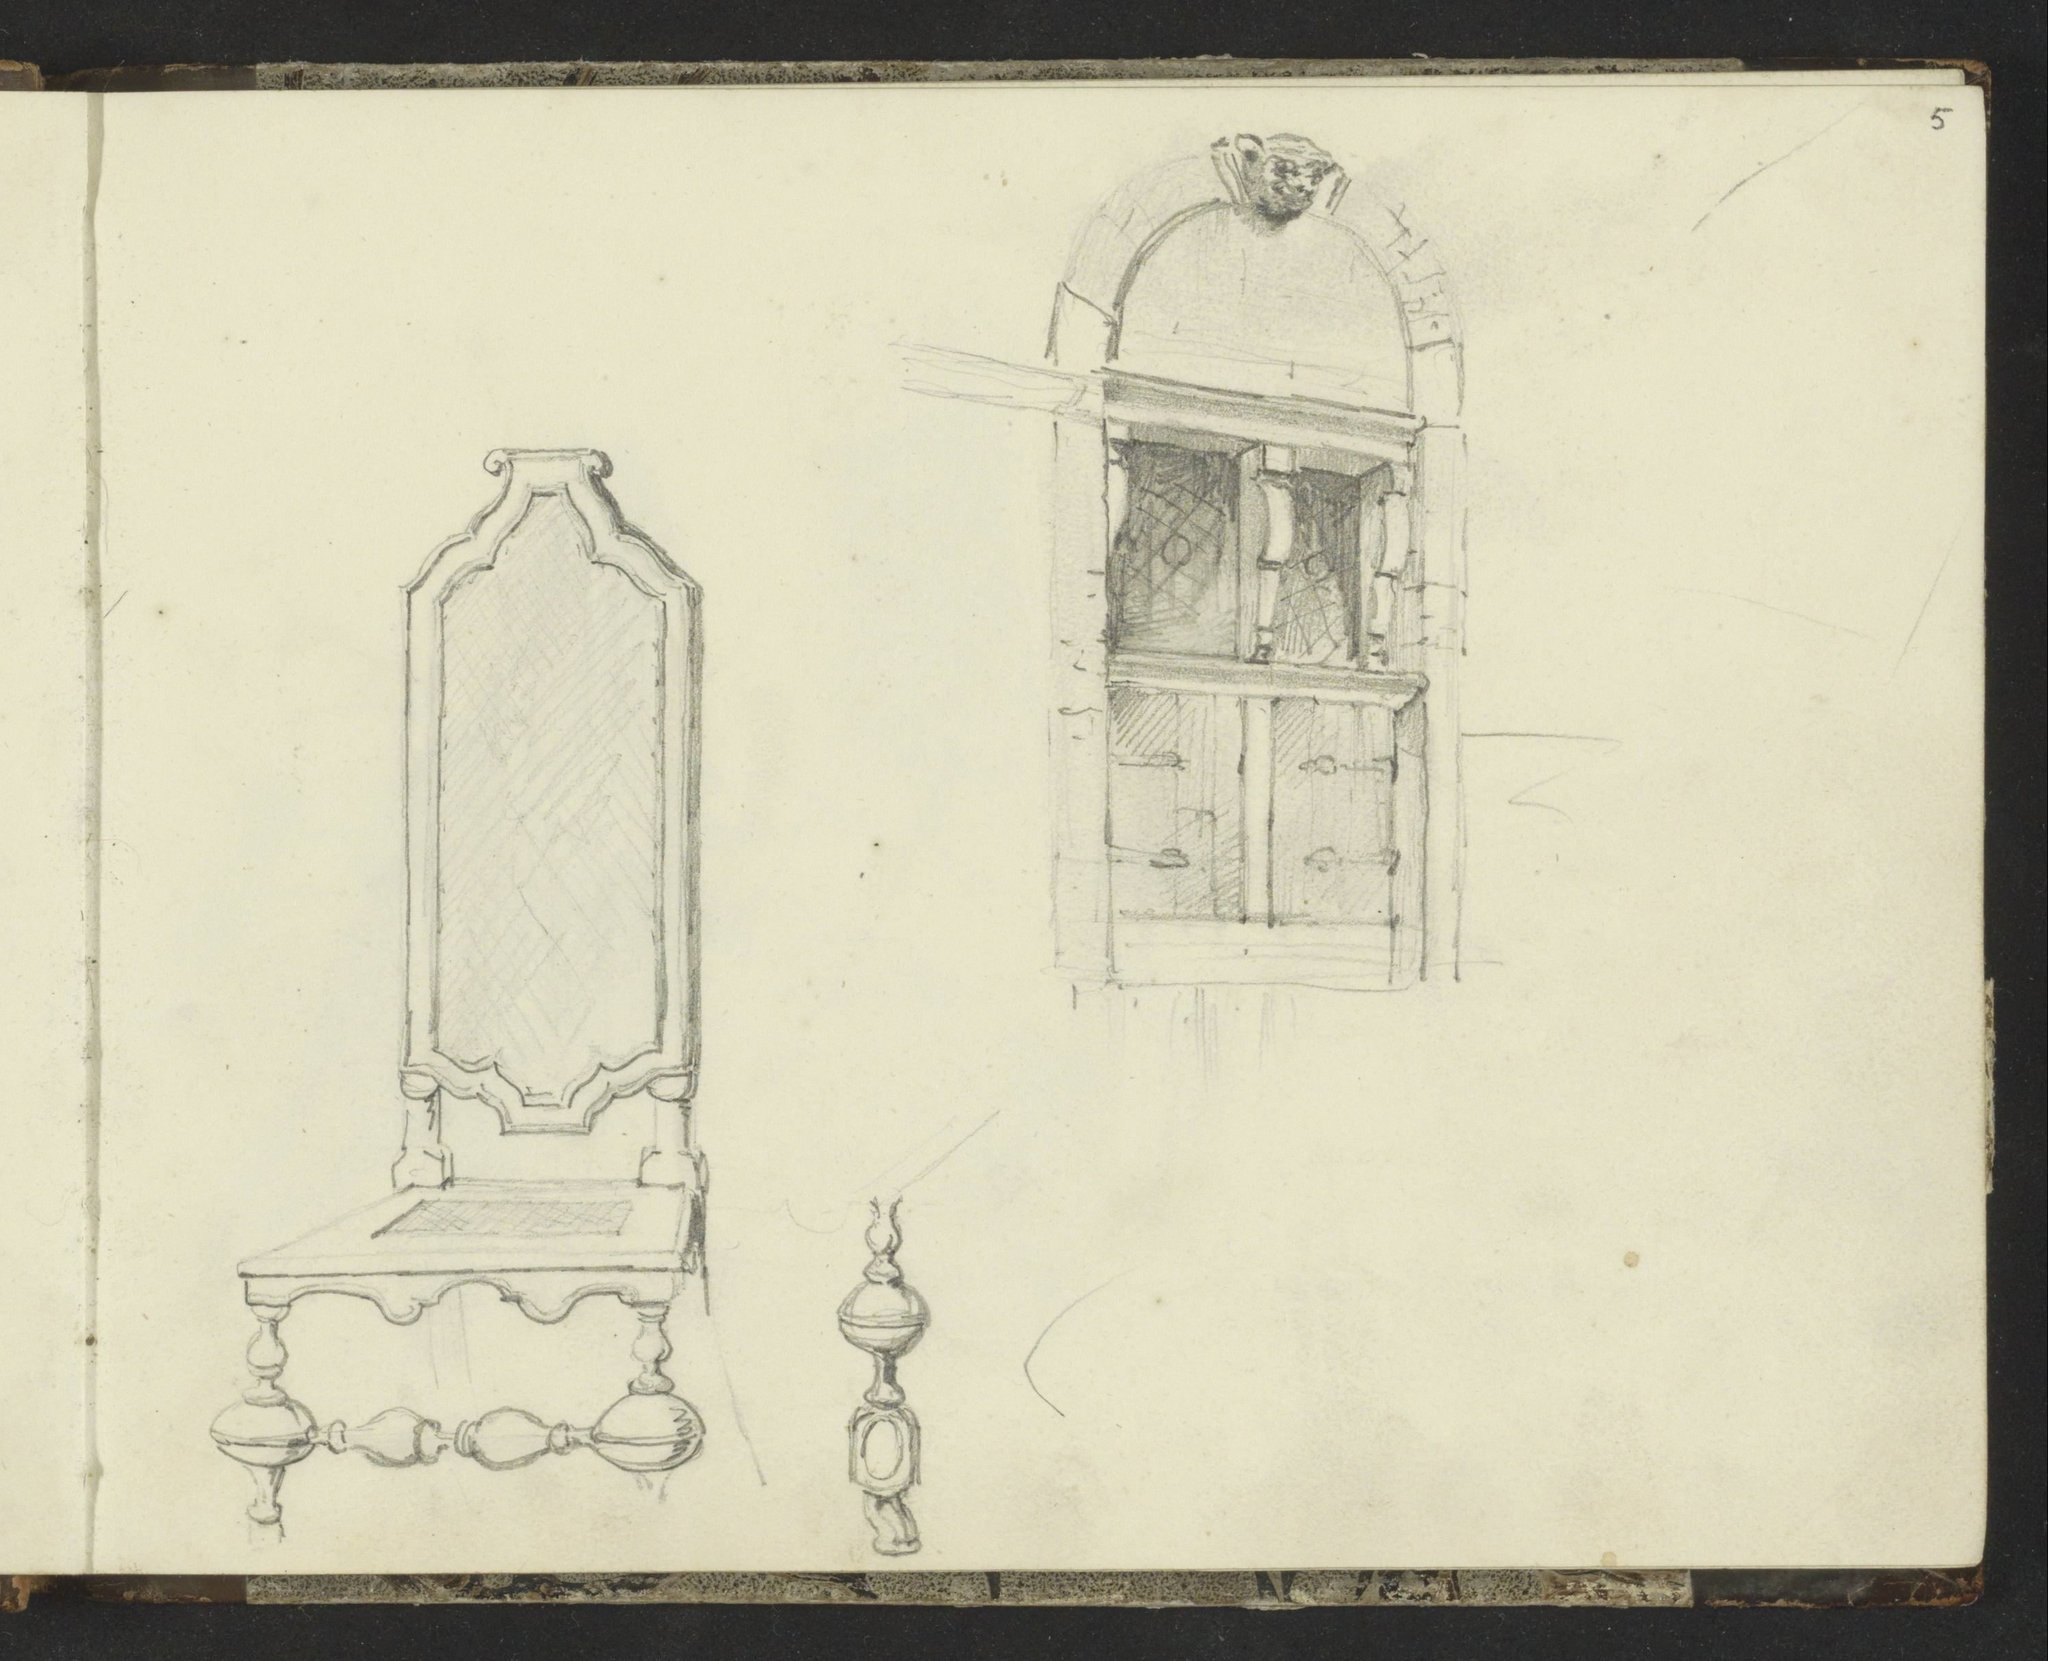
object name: sketchbook leaf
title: Stoel, een stoelpoot en een boogvenster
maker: willem hendrik schmidt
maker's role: draughtsman, painter, print maker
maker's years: 1809-1849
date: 1819-1849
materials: paper, pencil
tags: window, table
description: Blad 5 recto uit een schetsboek met 58 bladen.